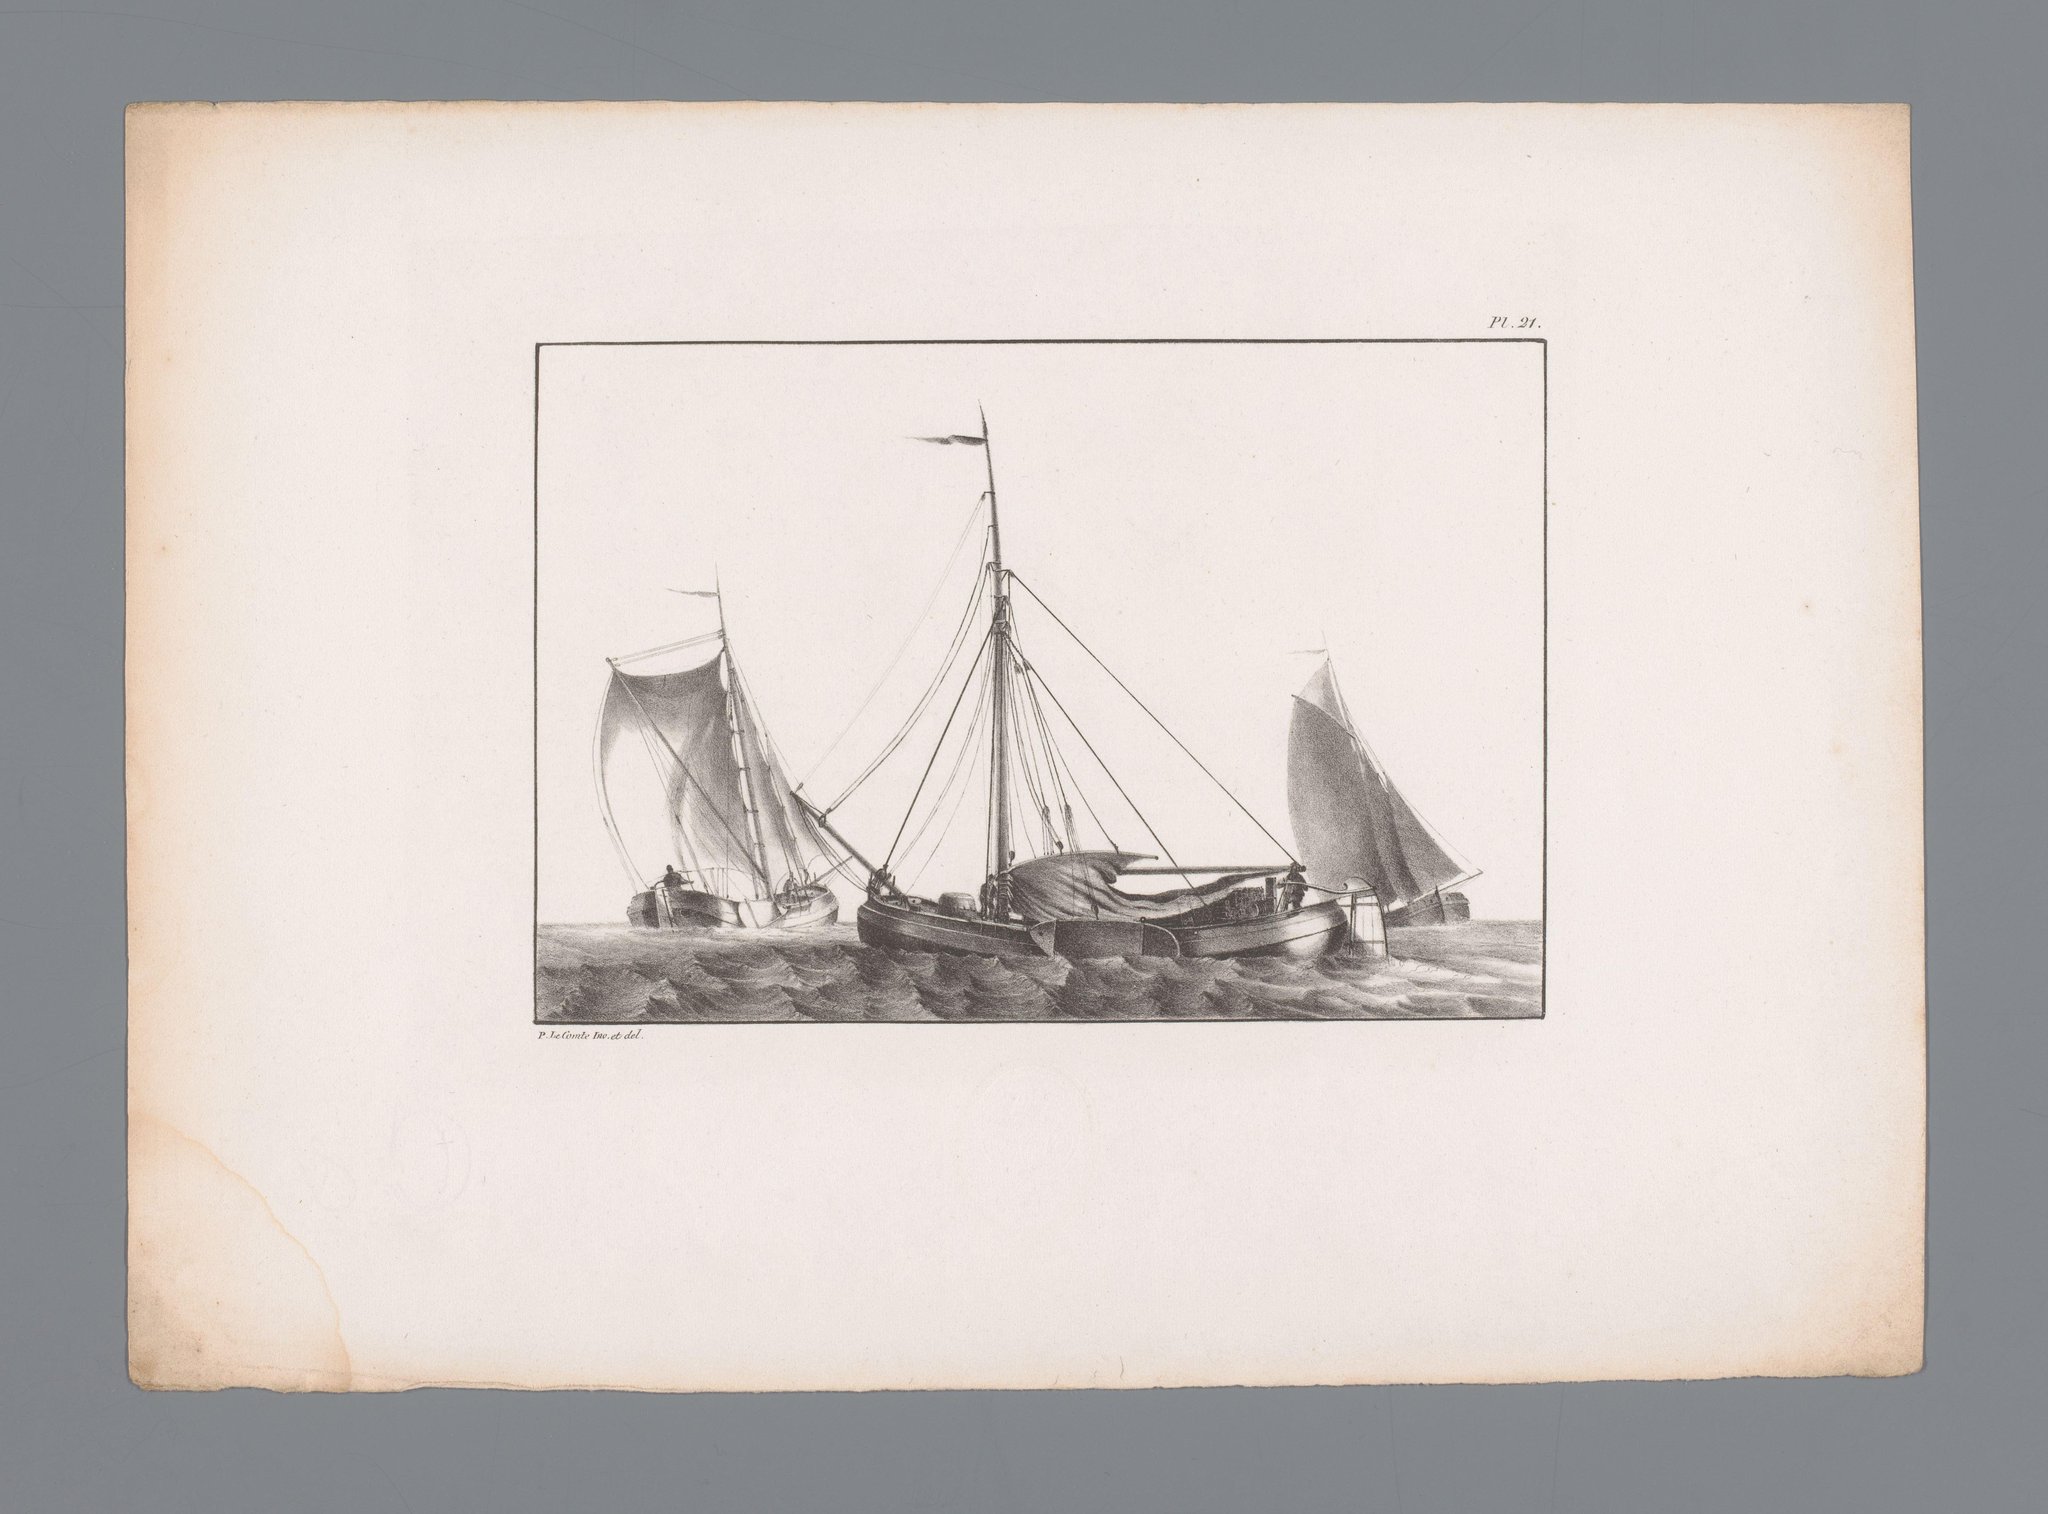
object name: print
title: Friese tjalk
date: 1831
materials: paper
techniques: lithograph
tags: sailing-ship, sailing-boat, ships (in general)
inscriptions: collector's mark: ‘PLC RMWO’, collector's mark: Lugt 2228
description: Drie boten waarvan een met gestreken zeil. Genummerd rechtsboven: Pl. 21. Deze prent maakt deel uit van een omslag met negentien prenten.